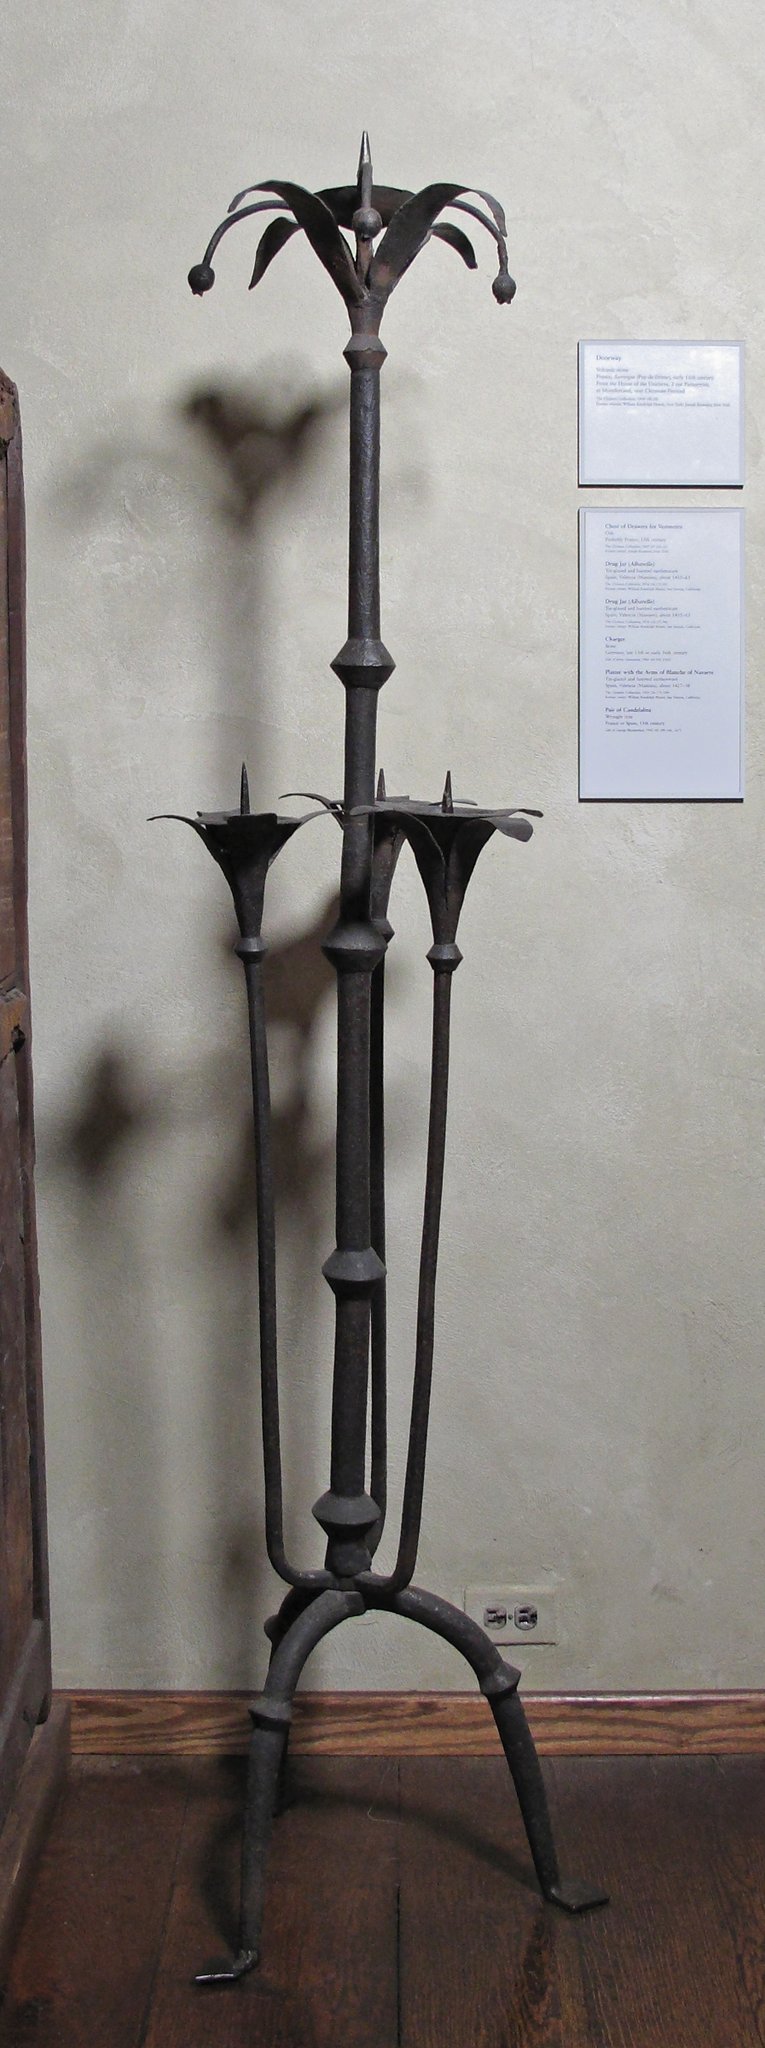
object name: candelabrum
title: One of a Pair of Candelabra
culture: french or spanish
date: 1401-1500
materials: iron